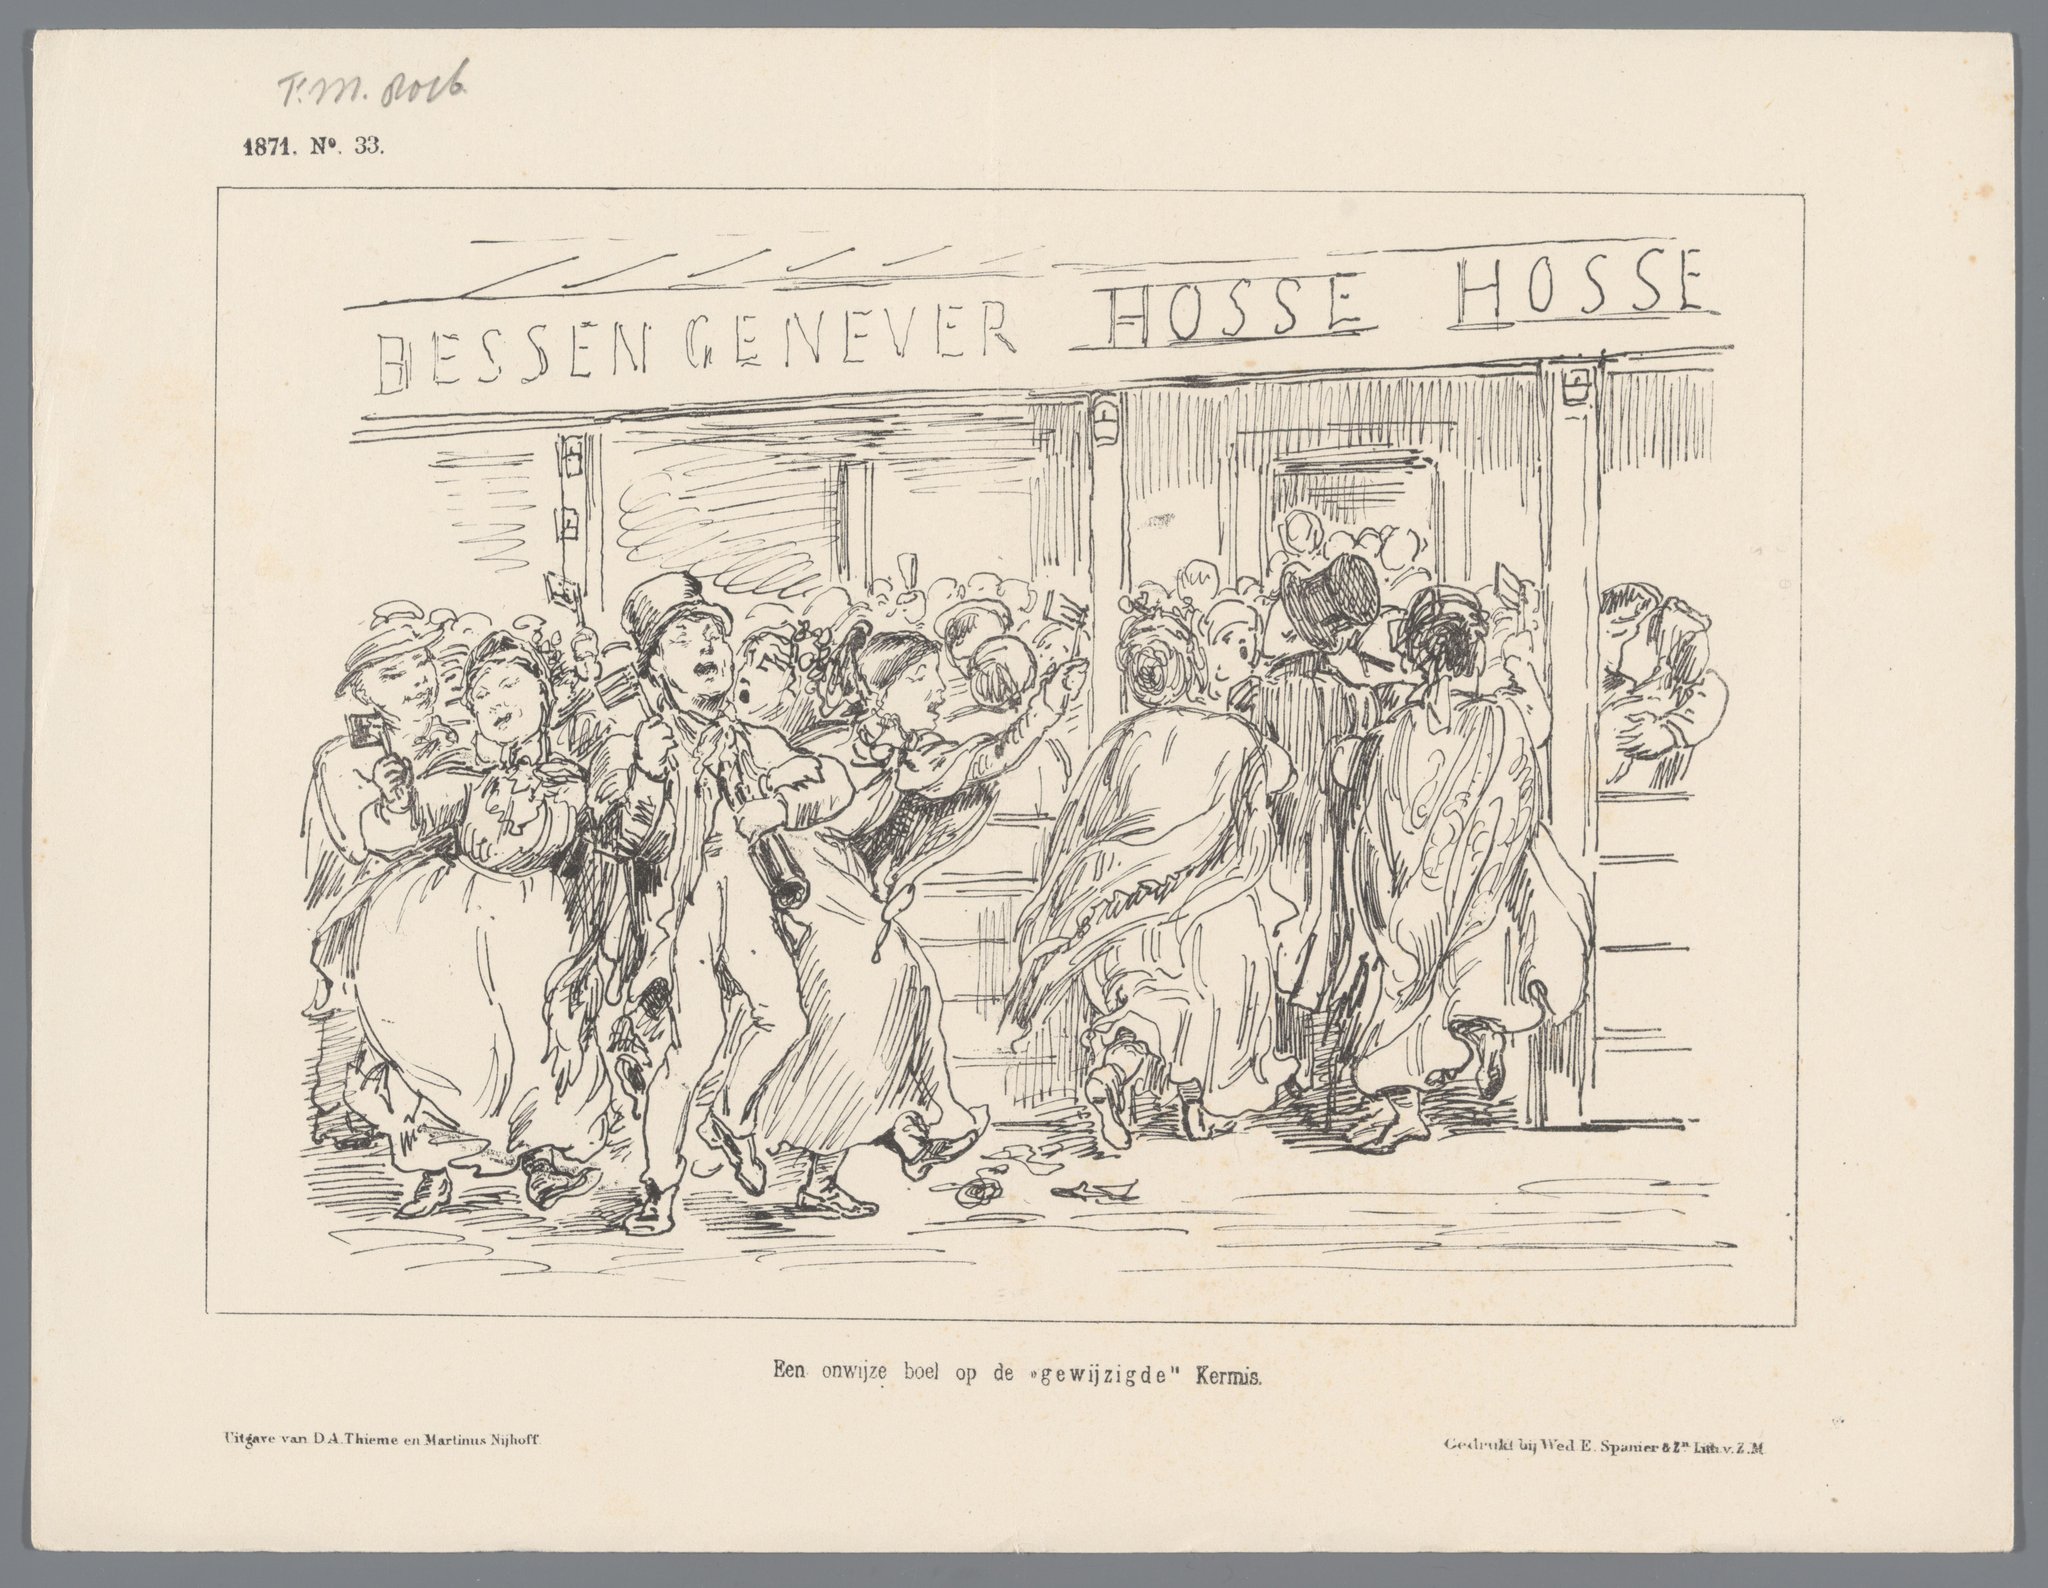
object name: print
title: Spotprent op de Haagse kermis, 1871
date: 1871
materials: paper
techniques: lithograph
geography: arnhem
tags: drunkenness, pleasure fair and circus, the hague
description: Spotprent nav de ongeregeldheden op de Haagse kermis. Plaat verschenen bij het weekblad De Nederlandsche Spectator, nr. 33, 1871.